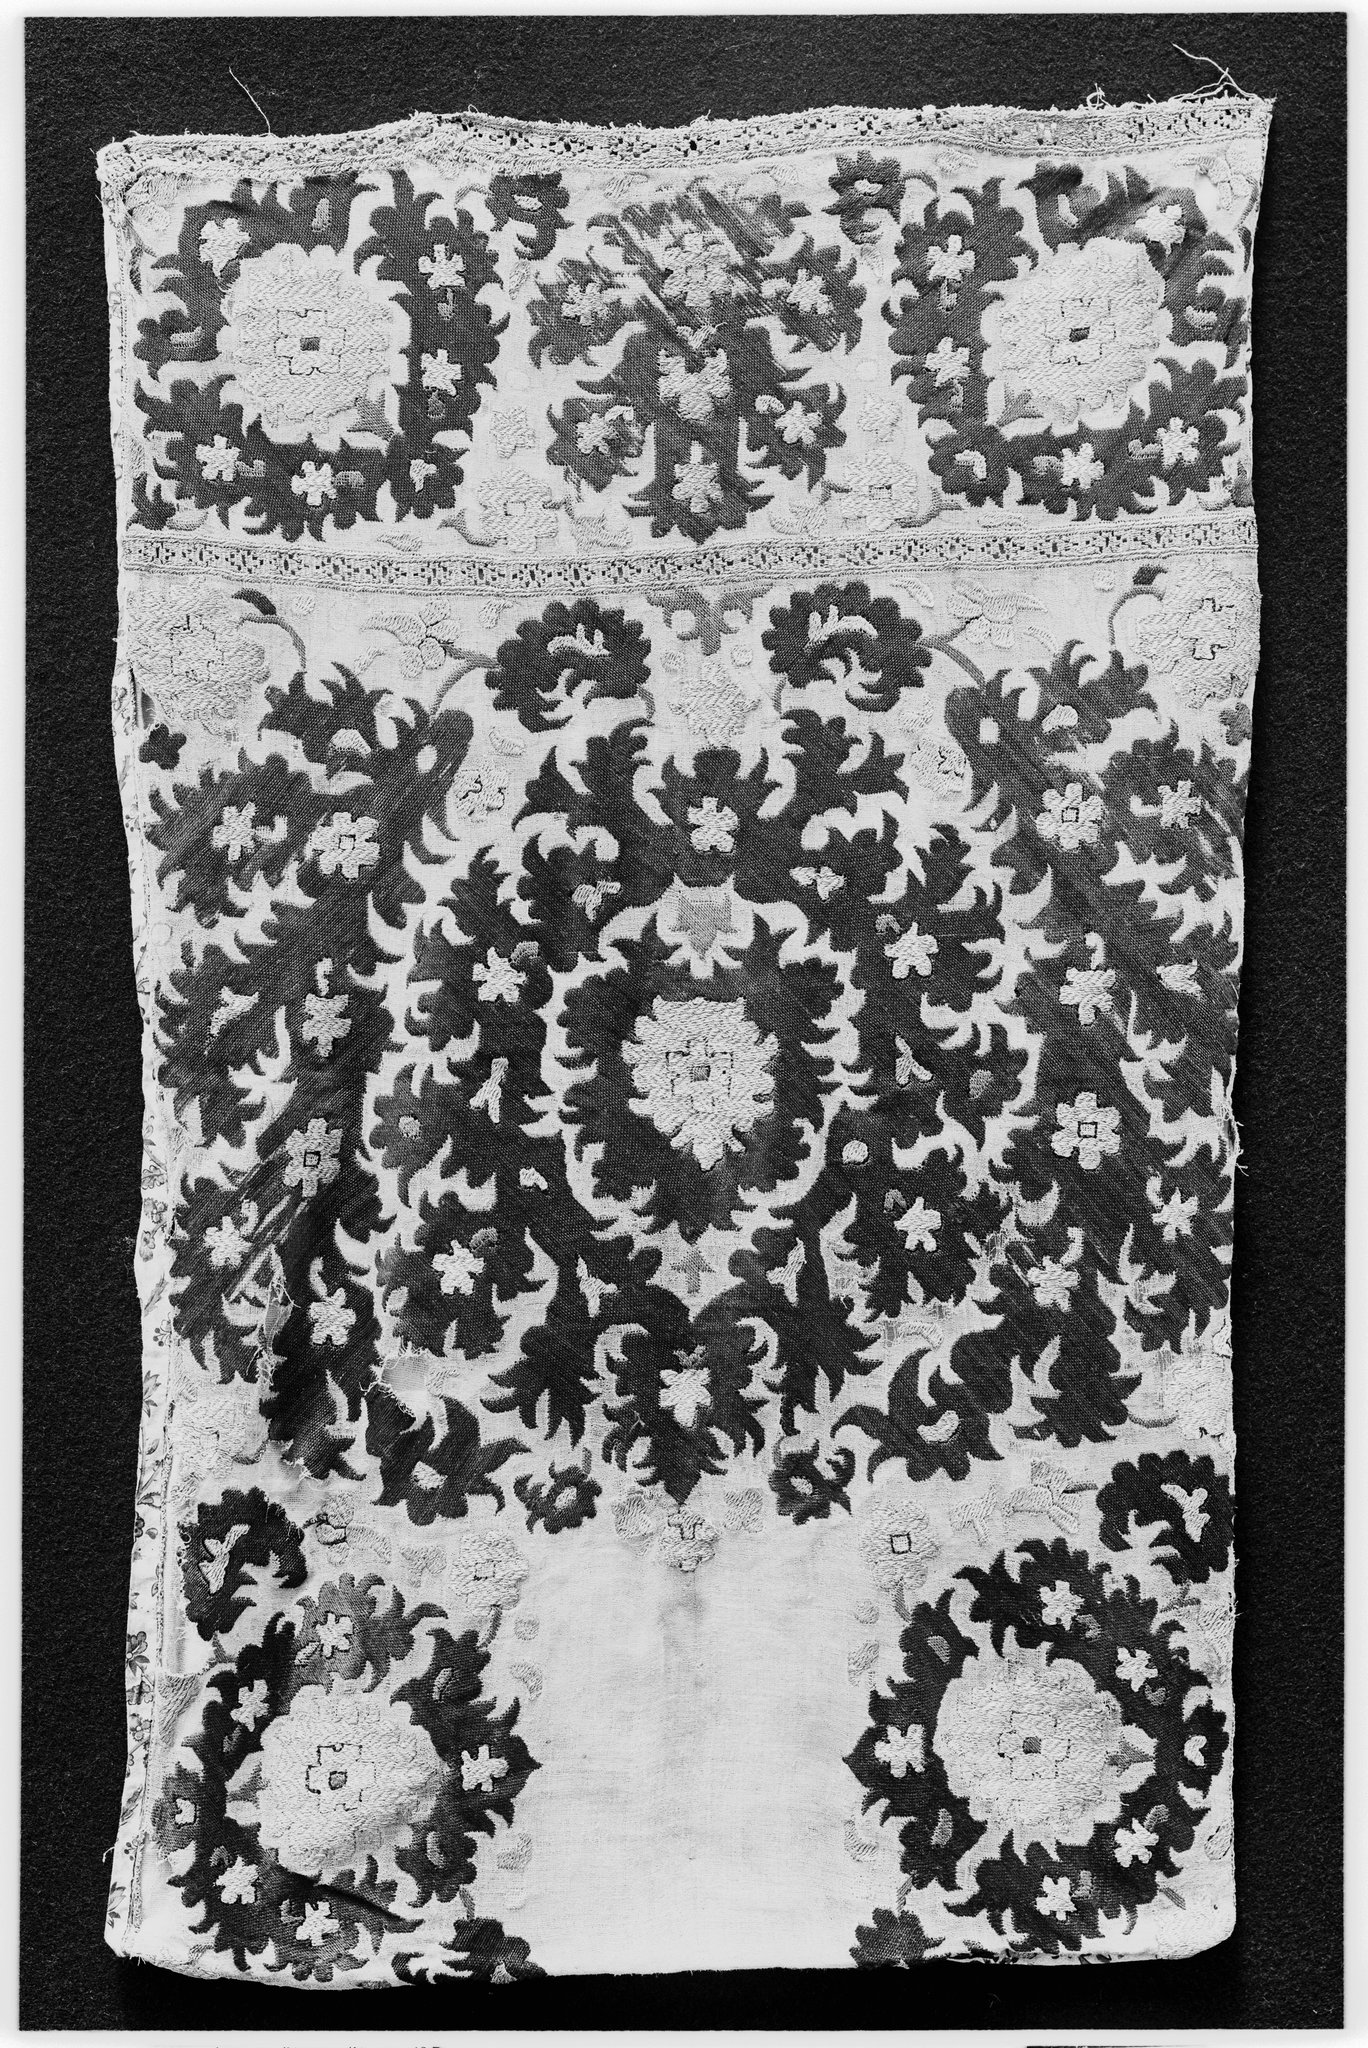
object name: scarf end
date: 1701-1800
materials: linen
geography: algeria